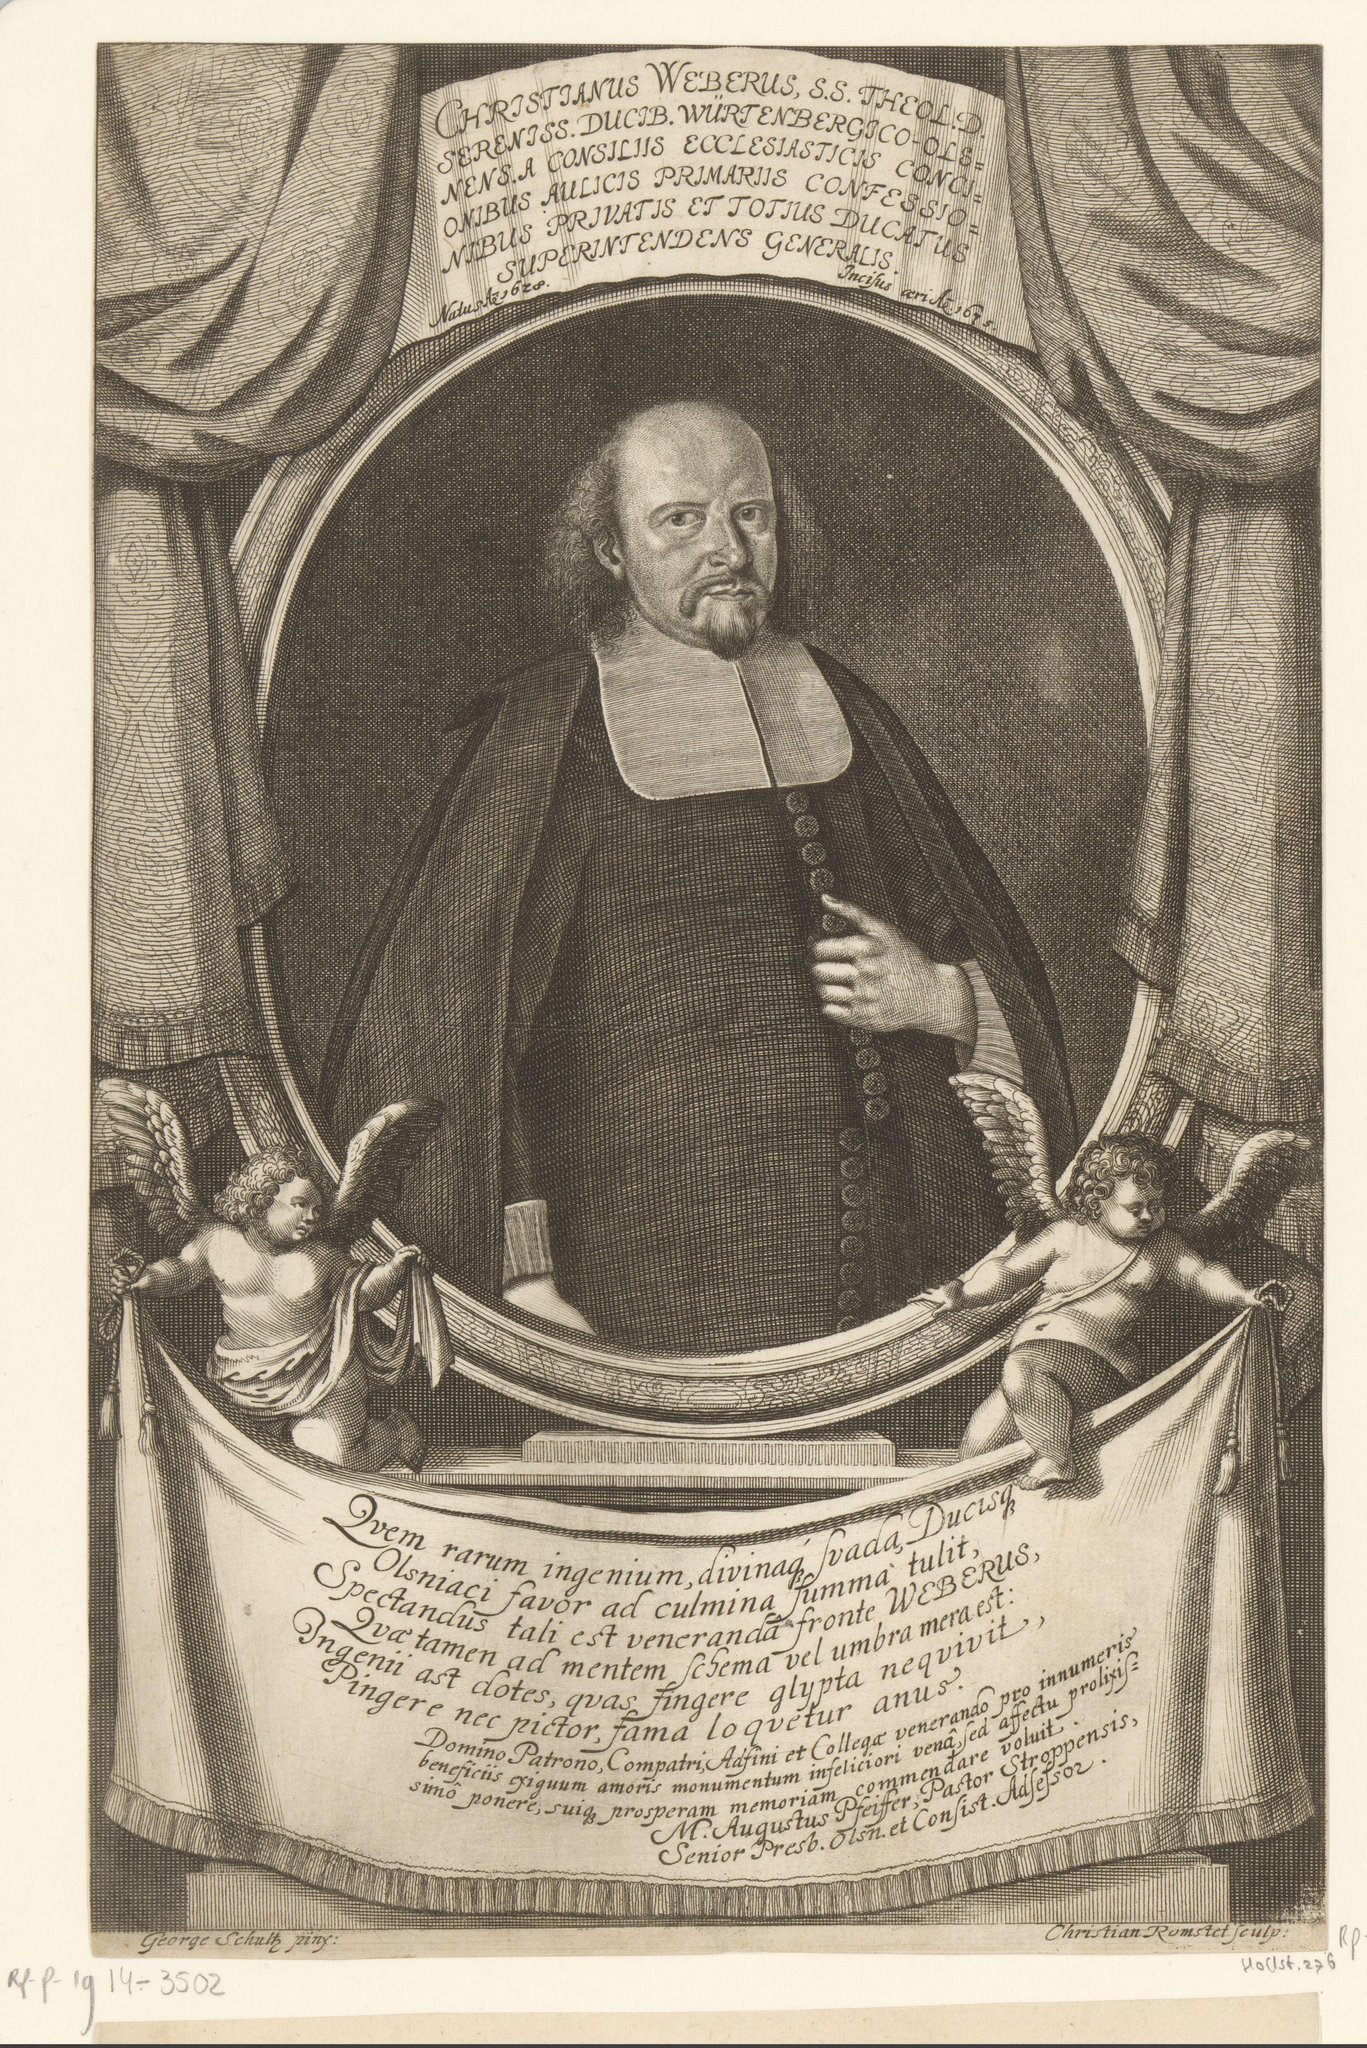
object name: print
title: Portret van Christian Weber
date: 1670-1721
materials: paper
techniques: engraving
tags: historical persons, cupids: 'amores', 'amoretti', 'putti'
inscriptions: collector's mark: Lugt 2228